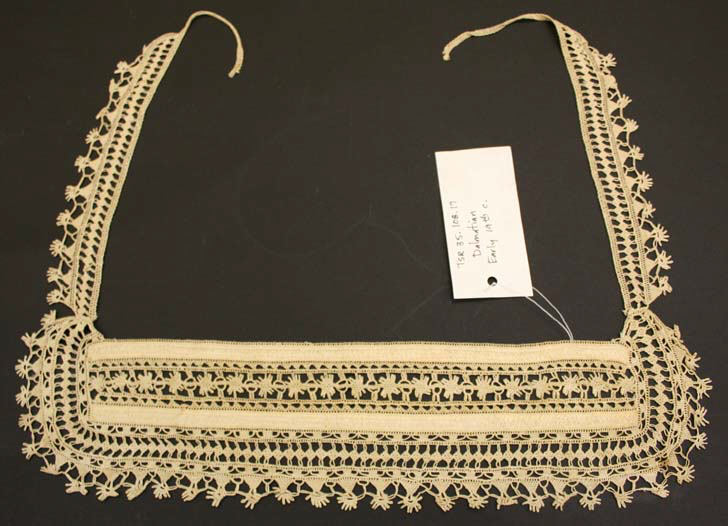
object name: collar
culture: croatian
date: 1801-1833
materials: linen